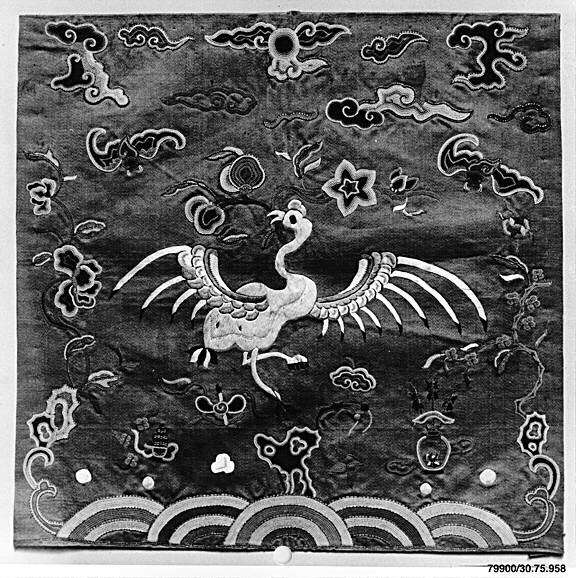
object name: rank badge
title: Rank Badge with Manchurian Crane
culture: chinese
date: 1701-1800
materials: metal thread, silk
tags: bats,cranes